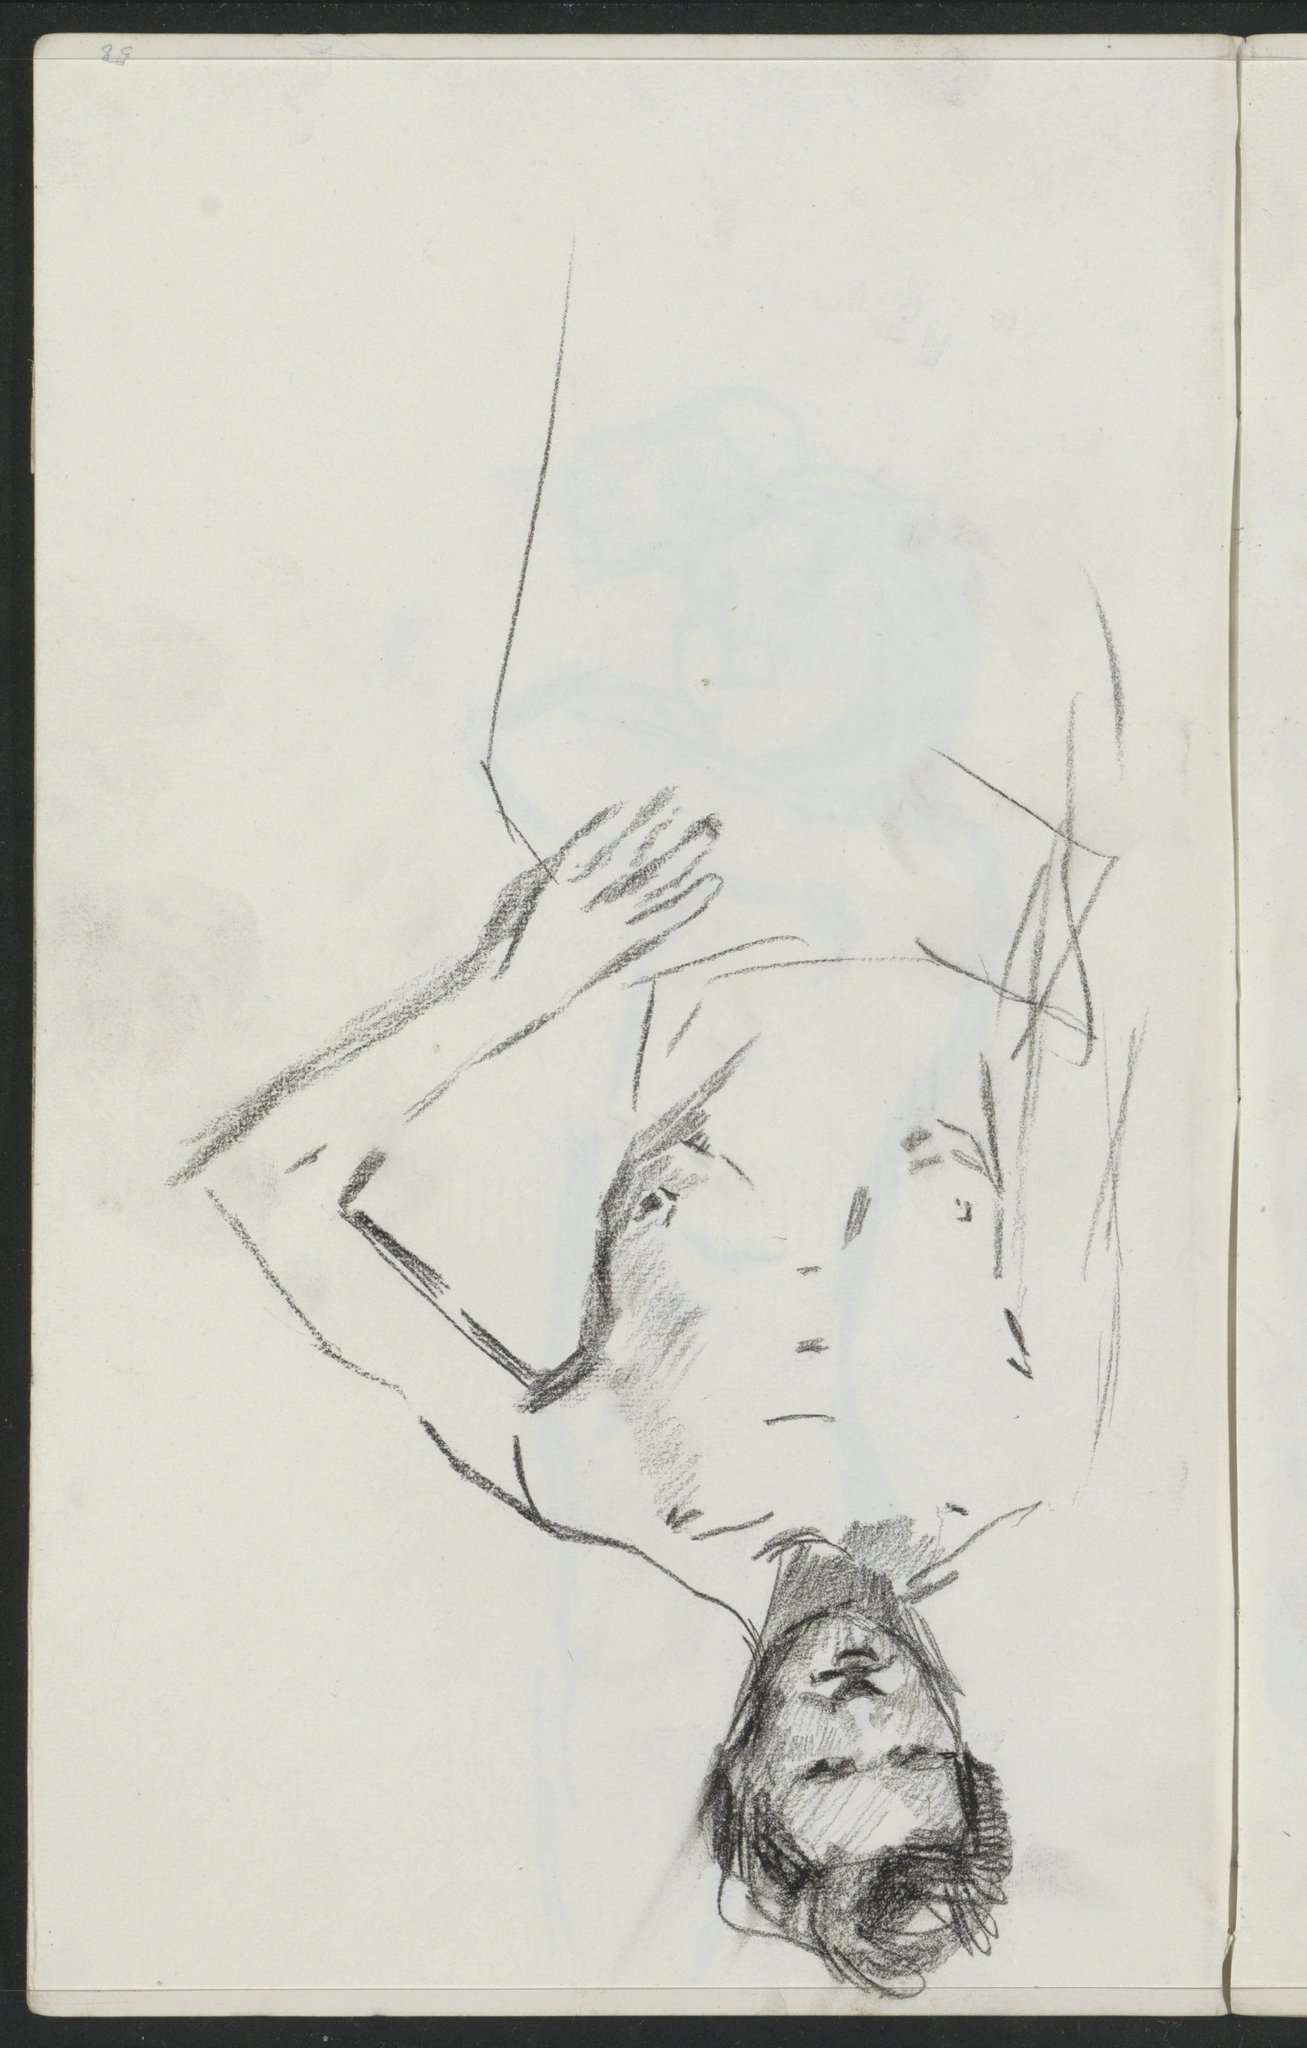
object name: sketchbook leaf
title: Standing Female Nude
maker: isaac israels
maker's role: draughtsman, painter, print maker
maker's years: 1865-1934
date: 1875-1934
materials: chalk, paper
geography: amsterdam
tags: the (nude) human figure; 'corpo humano' (ripa) - aa - female human figure (+ standing)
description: Blad 3 verso uit schetsboek XI met 30 bladen.